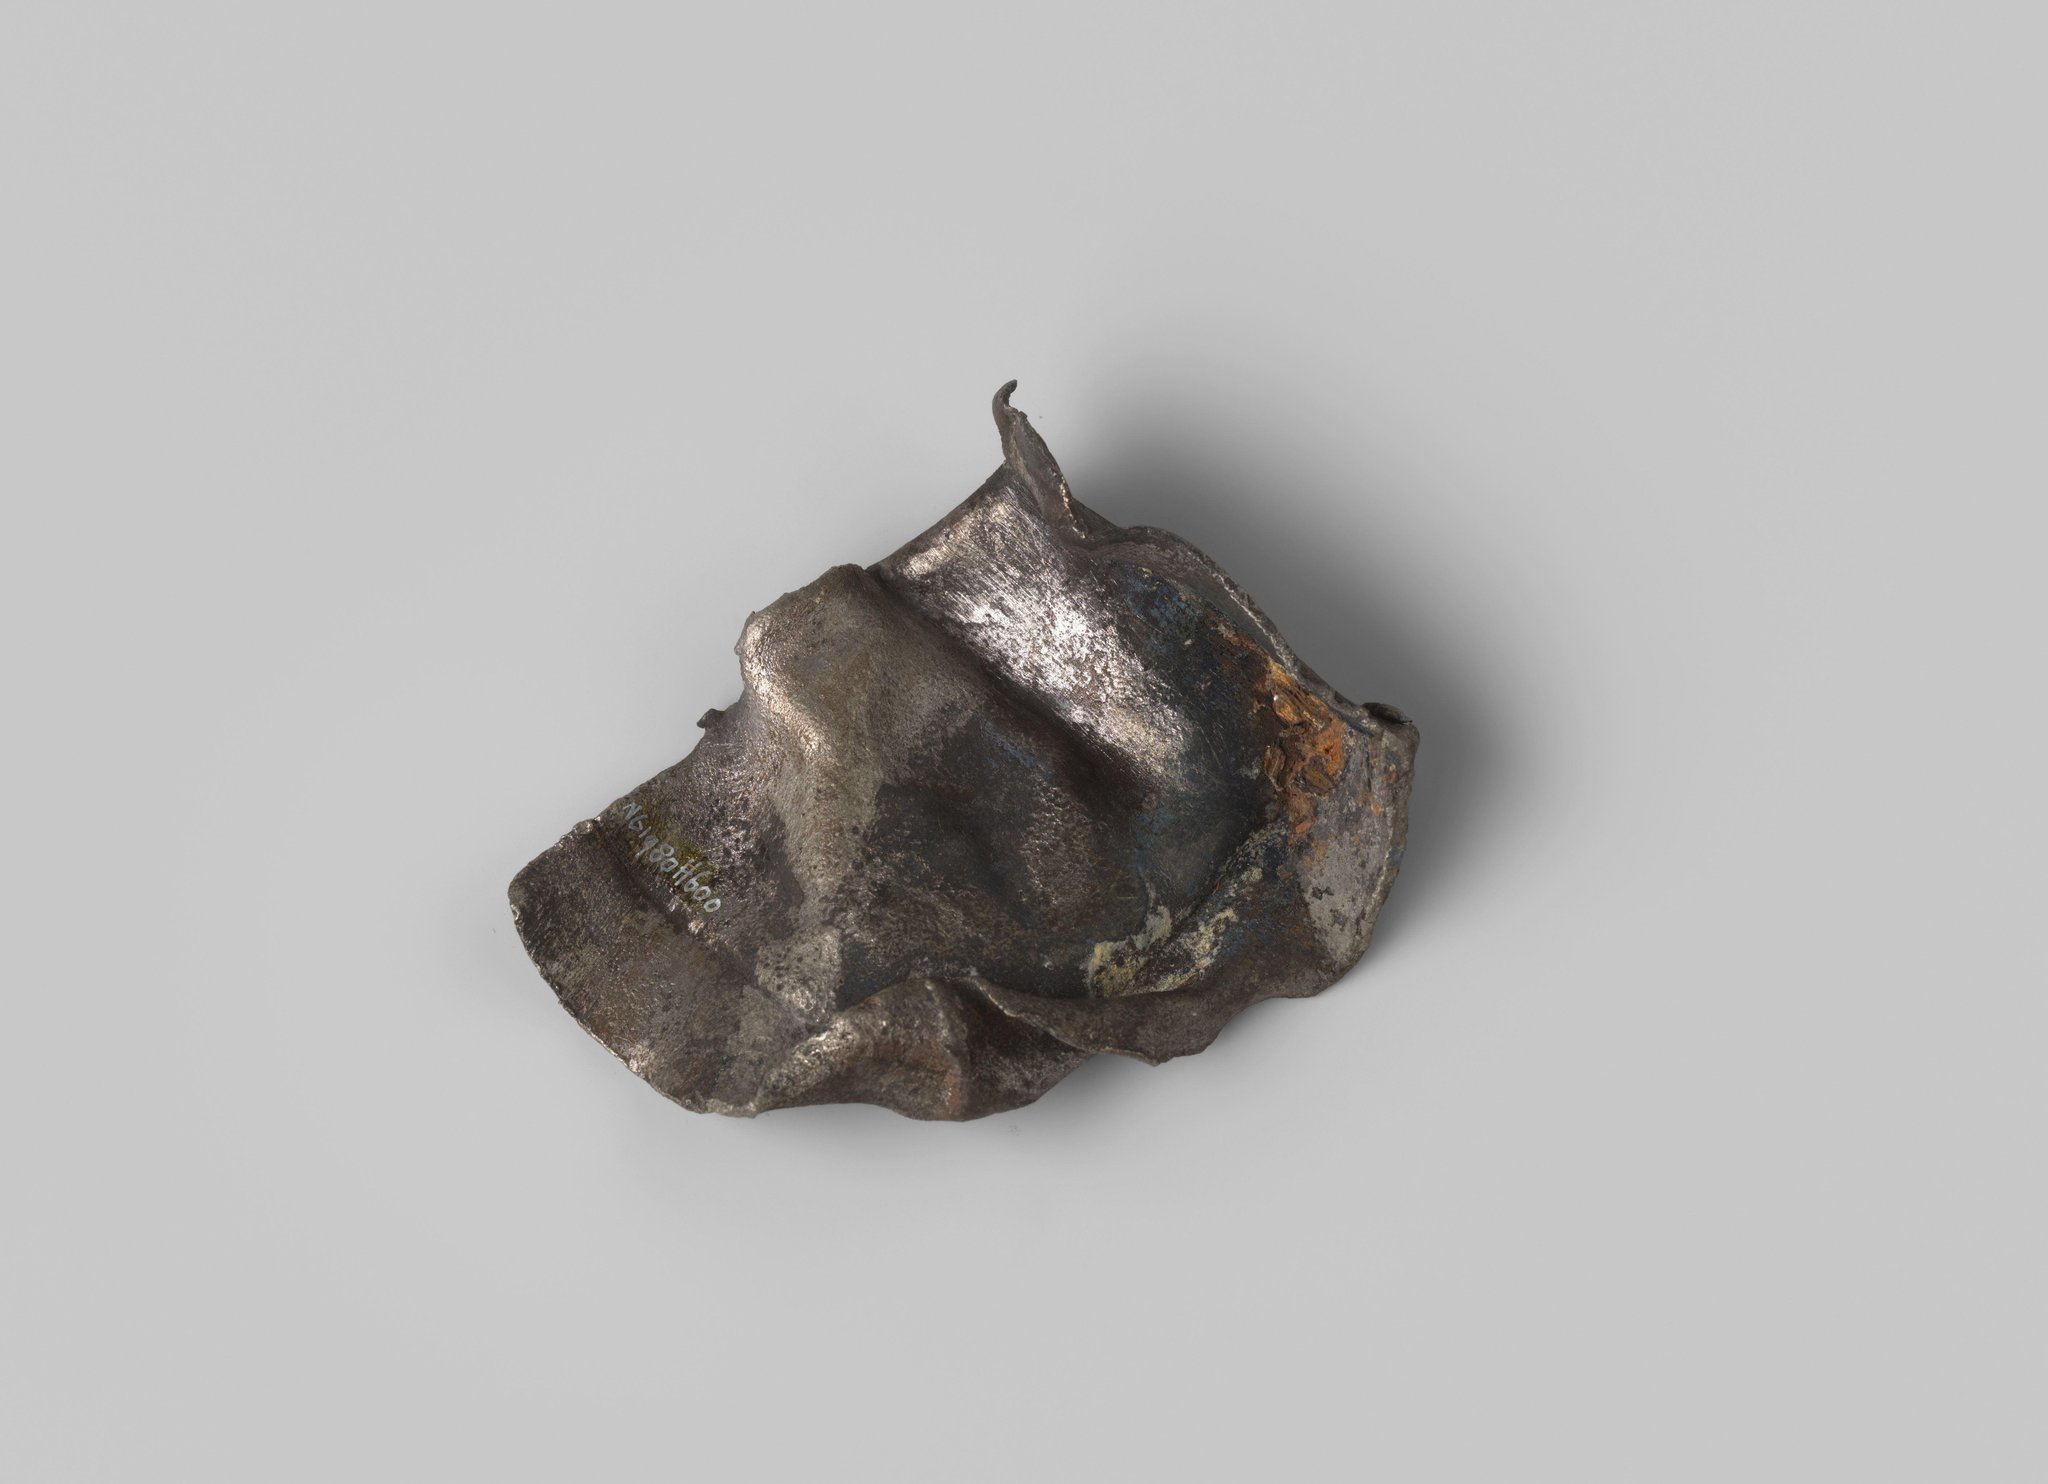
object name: verpakking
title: Deksel van een verpakking uit het wrak van de Oost-Indiëvaarder Hollandia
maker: Anonymous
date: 1700-1743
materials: tin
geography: netherlands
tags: verenigde oostindische compagnie, hollandia (schip), annet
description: Container, lid; fragm, part of NG 1980-27H618, squashed.